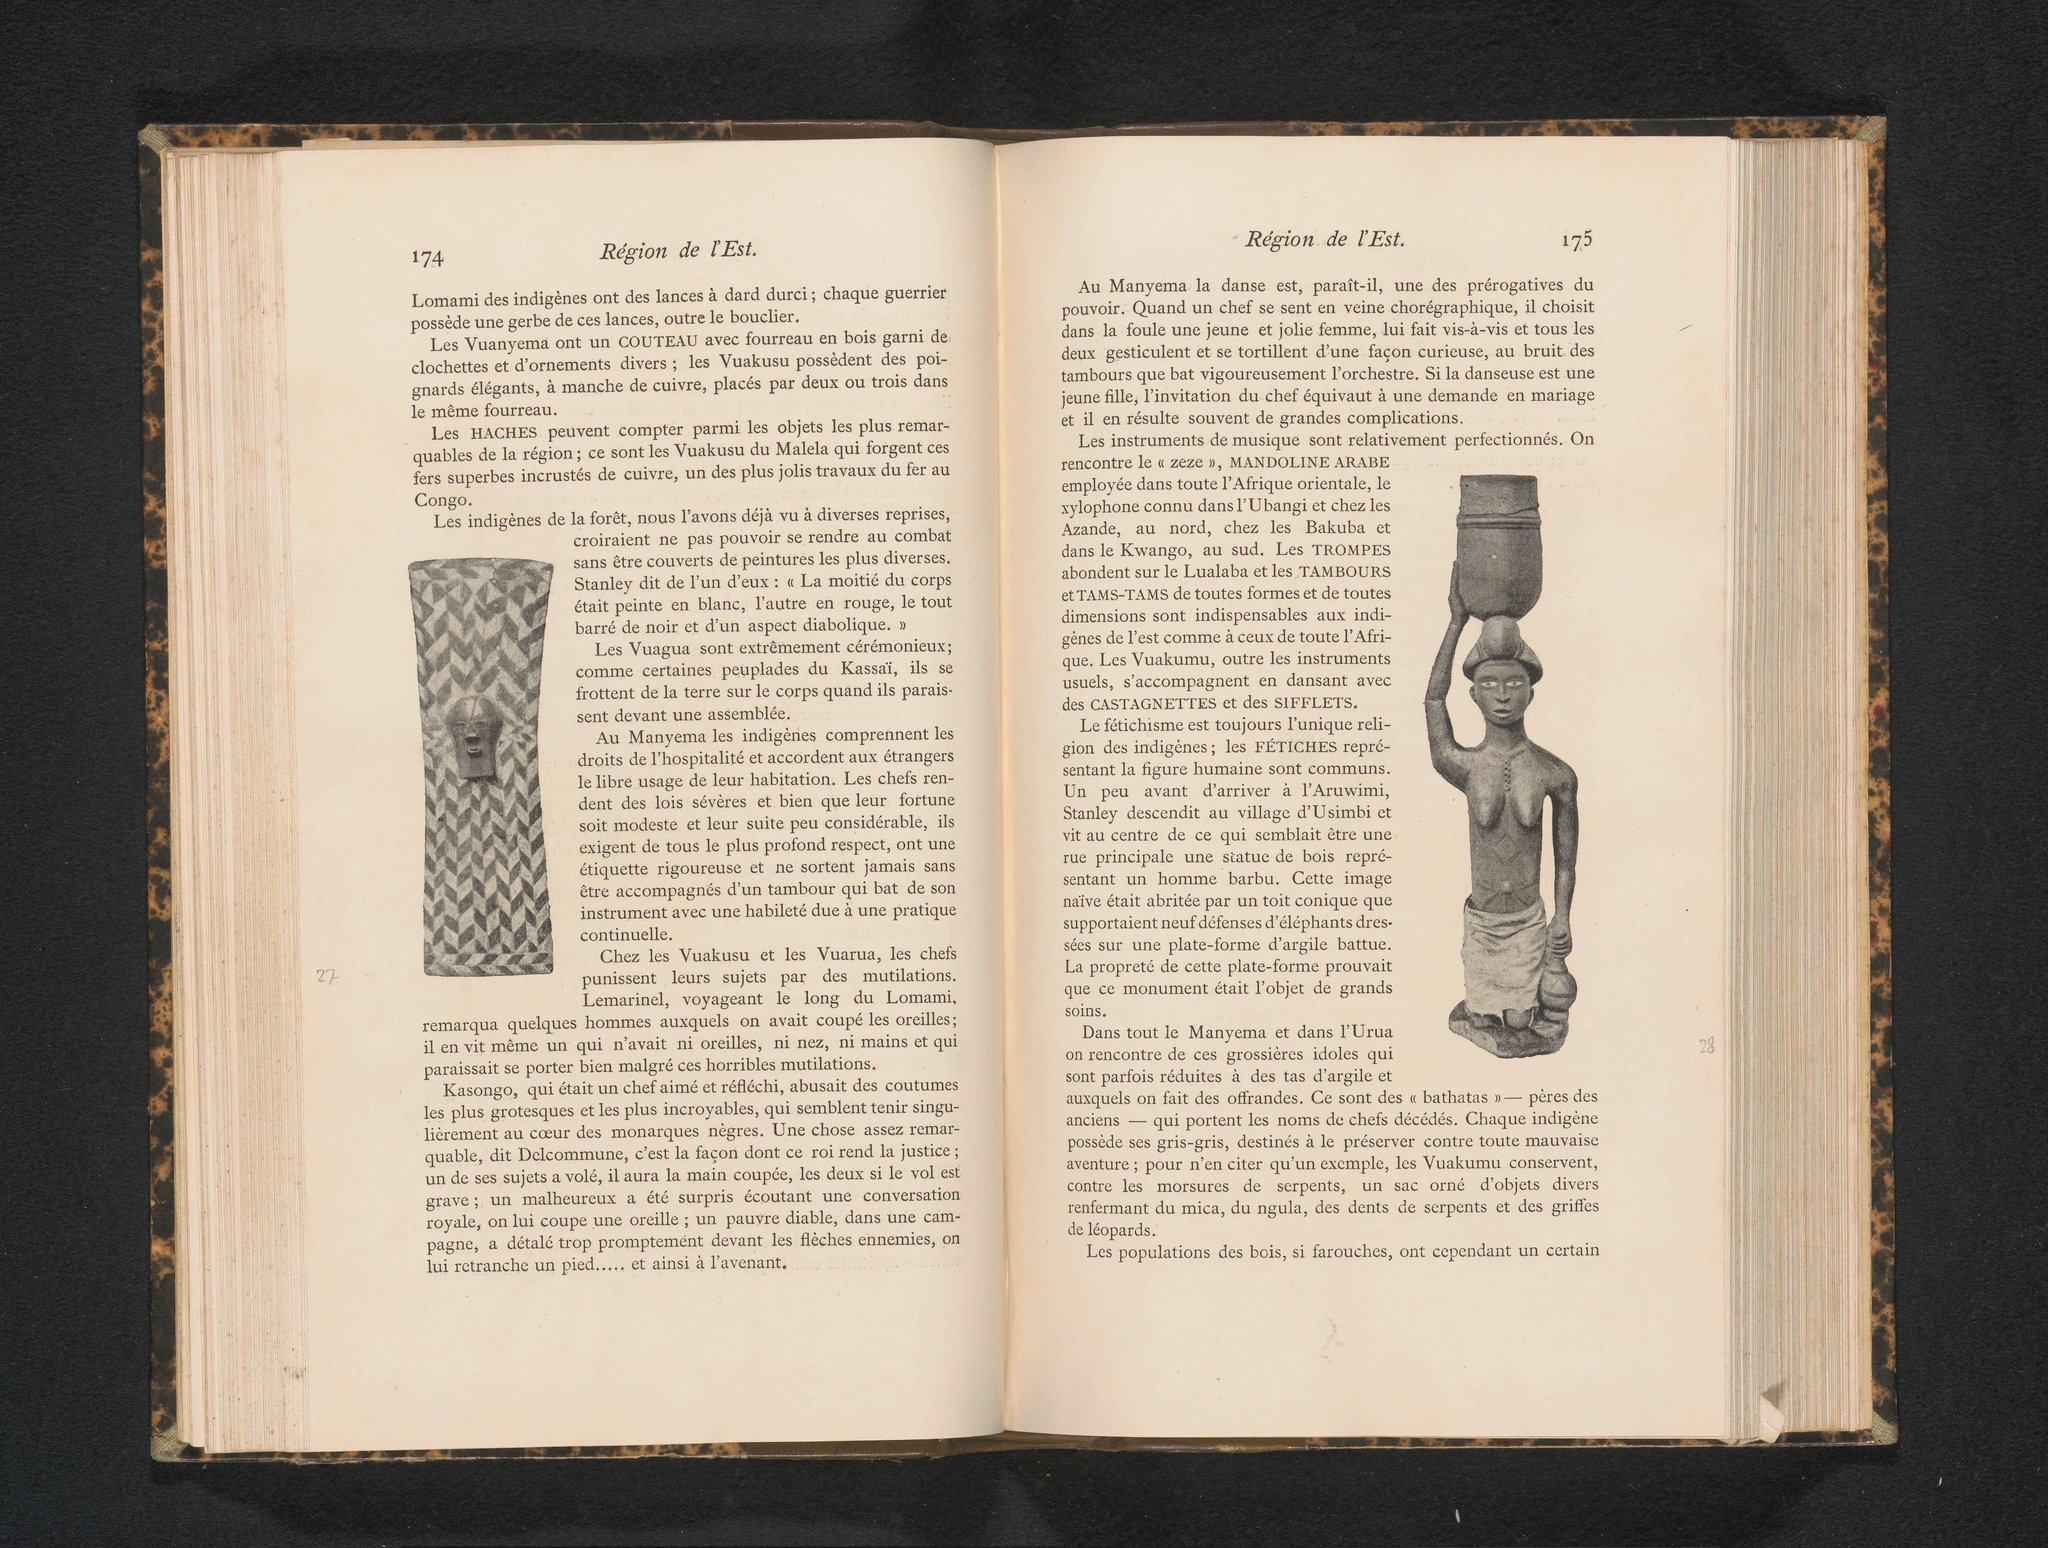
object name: photomechanical print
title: Beeldhouwwerk uit Congo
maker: Anonymous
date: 1887-1892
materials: paper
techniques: autotype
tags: sculpture (+ wood, e.g.: panel ~ arts)